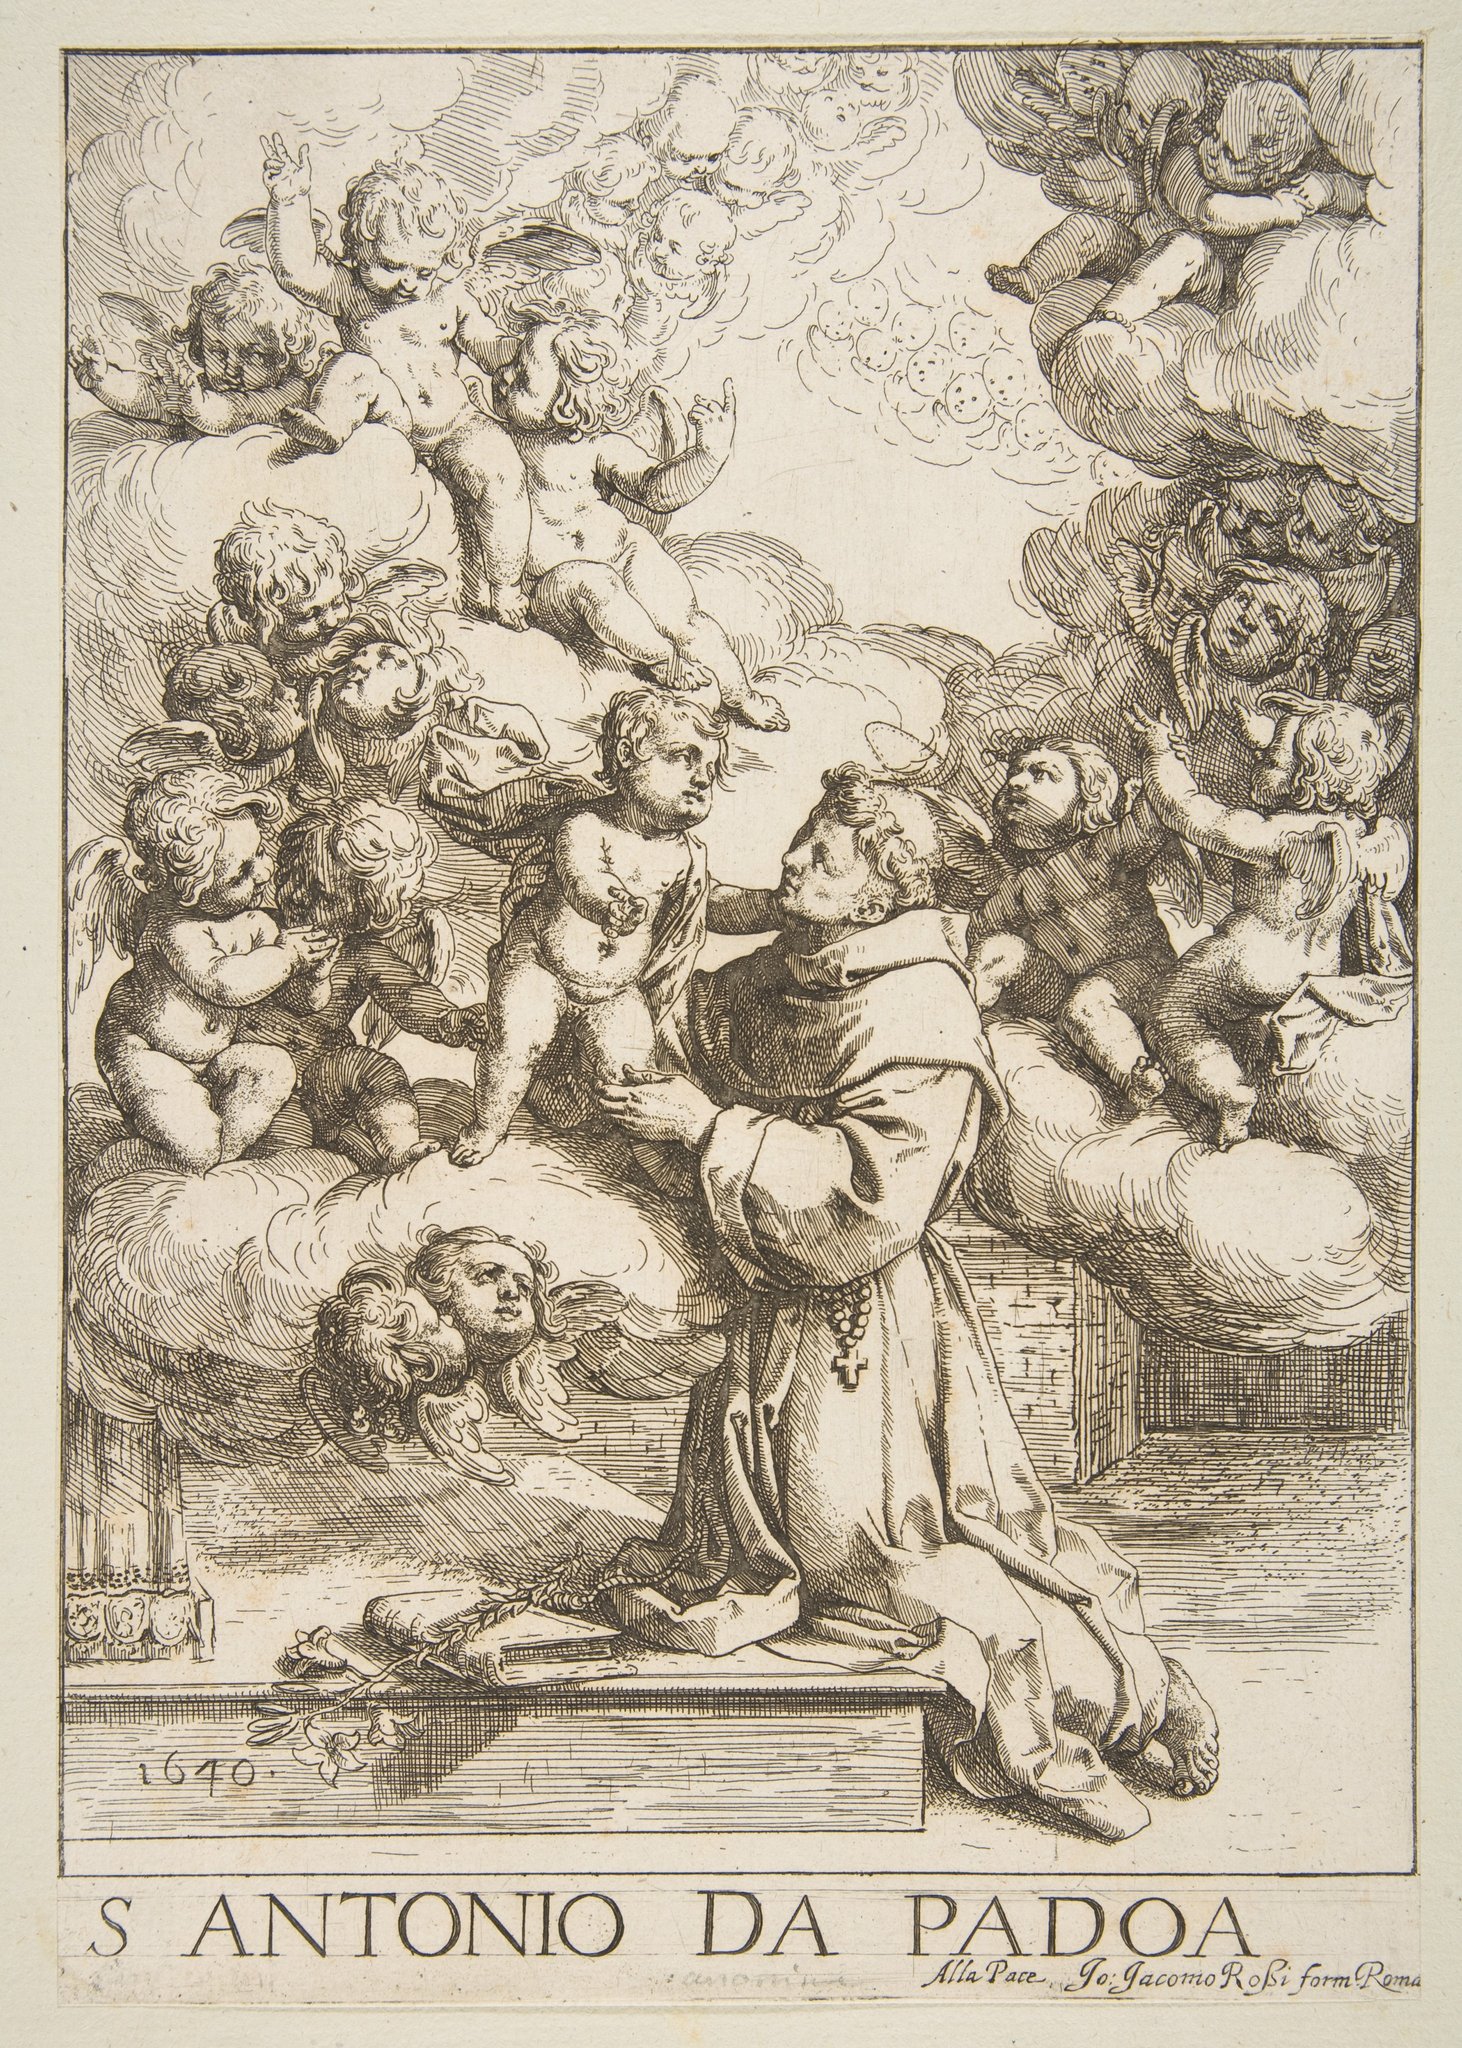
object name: print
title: Saint Anthony of Padua adoring the Christ Child, copy after Cantarini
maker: anonymous, italian, 17th century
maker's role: artist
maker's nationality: italian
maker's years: 1600-1700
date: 1640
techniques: etching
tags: angels,saint anthony,jesus